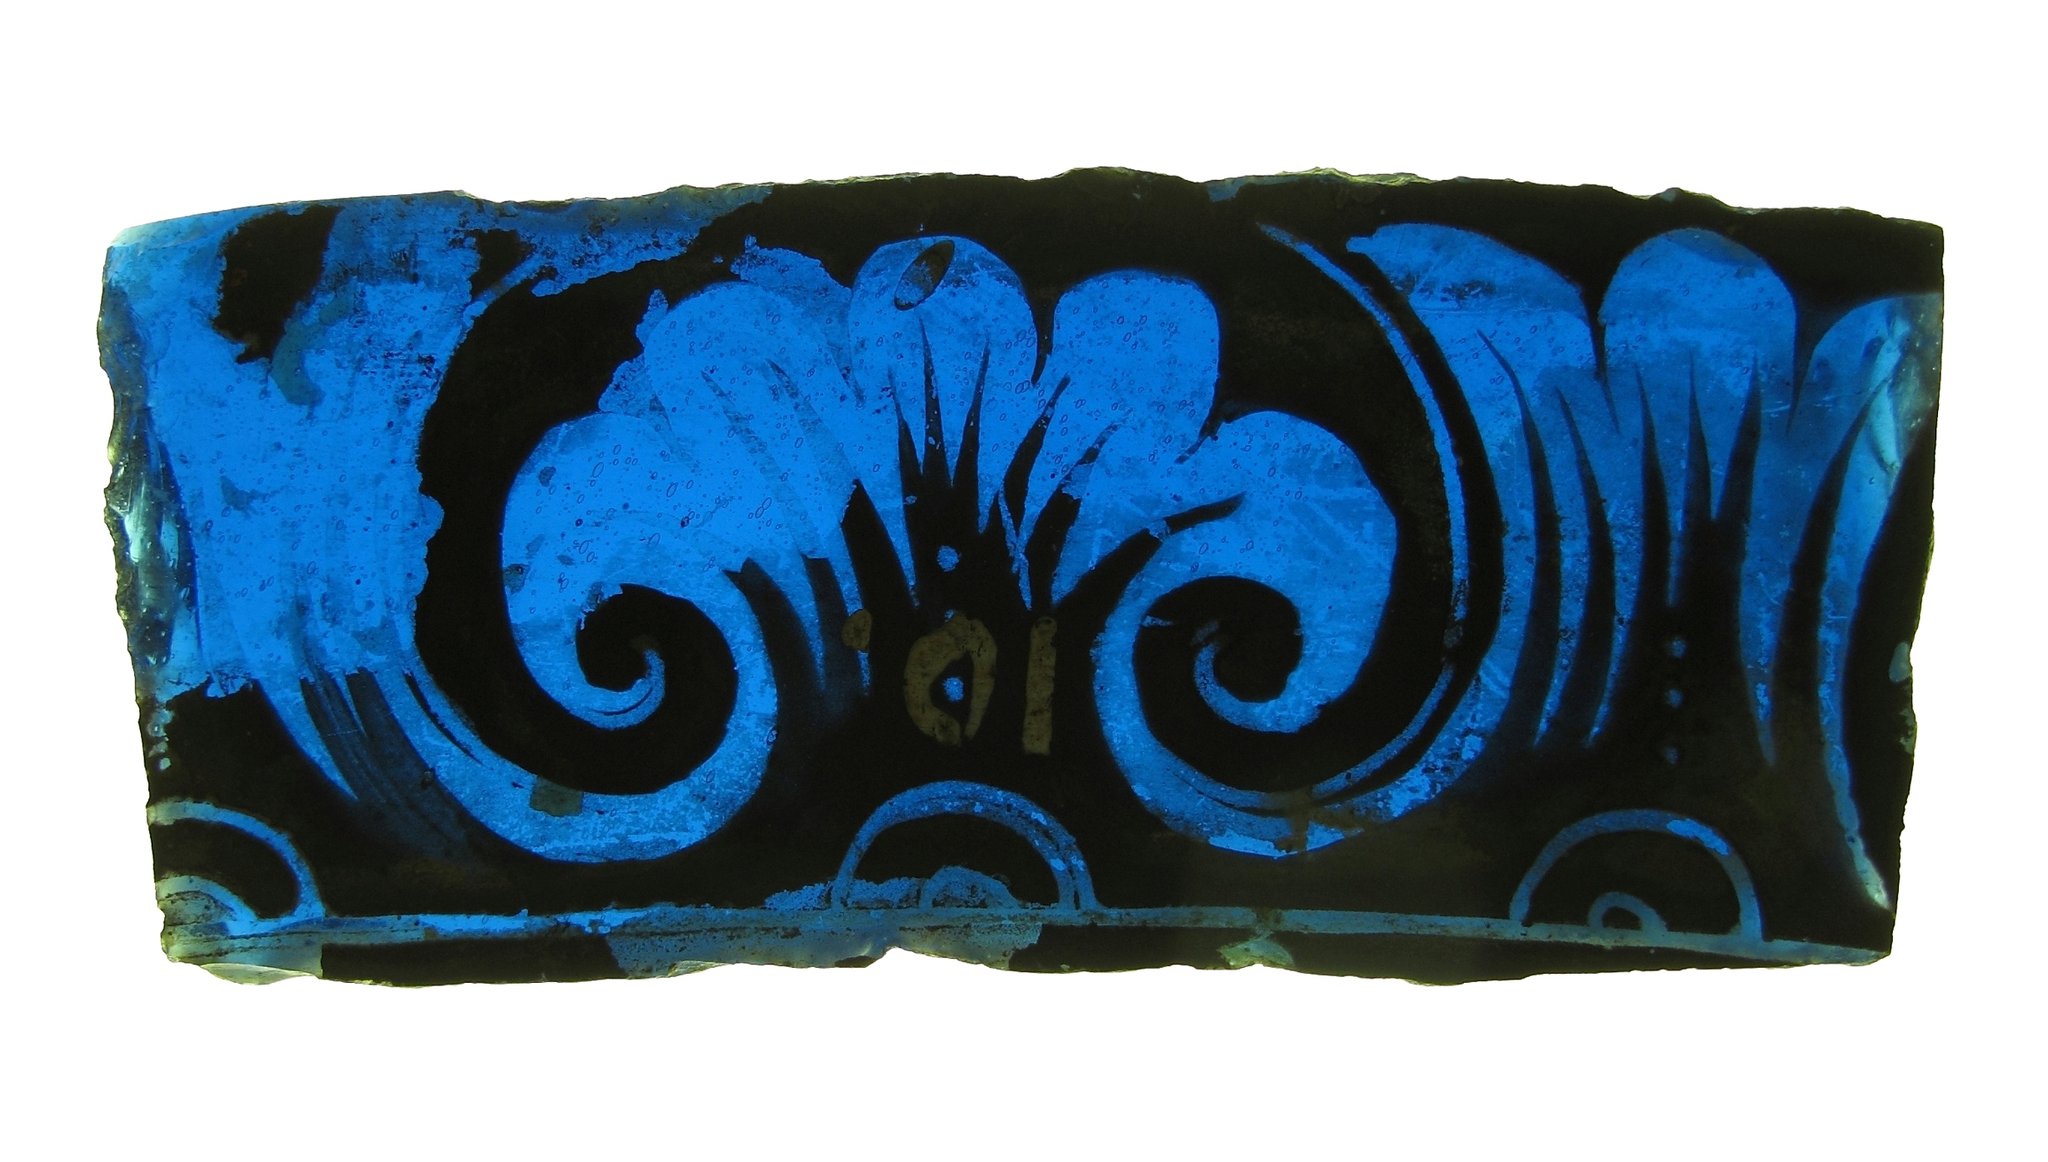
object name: fragment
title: Glass Fragment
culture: french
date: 1201-1300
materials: glass, metal